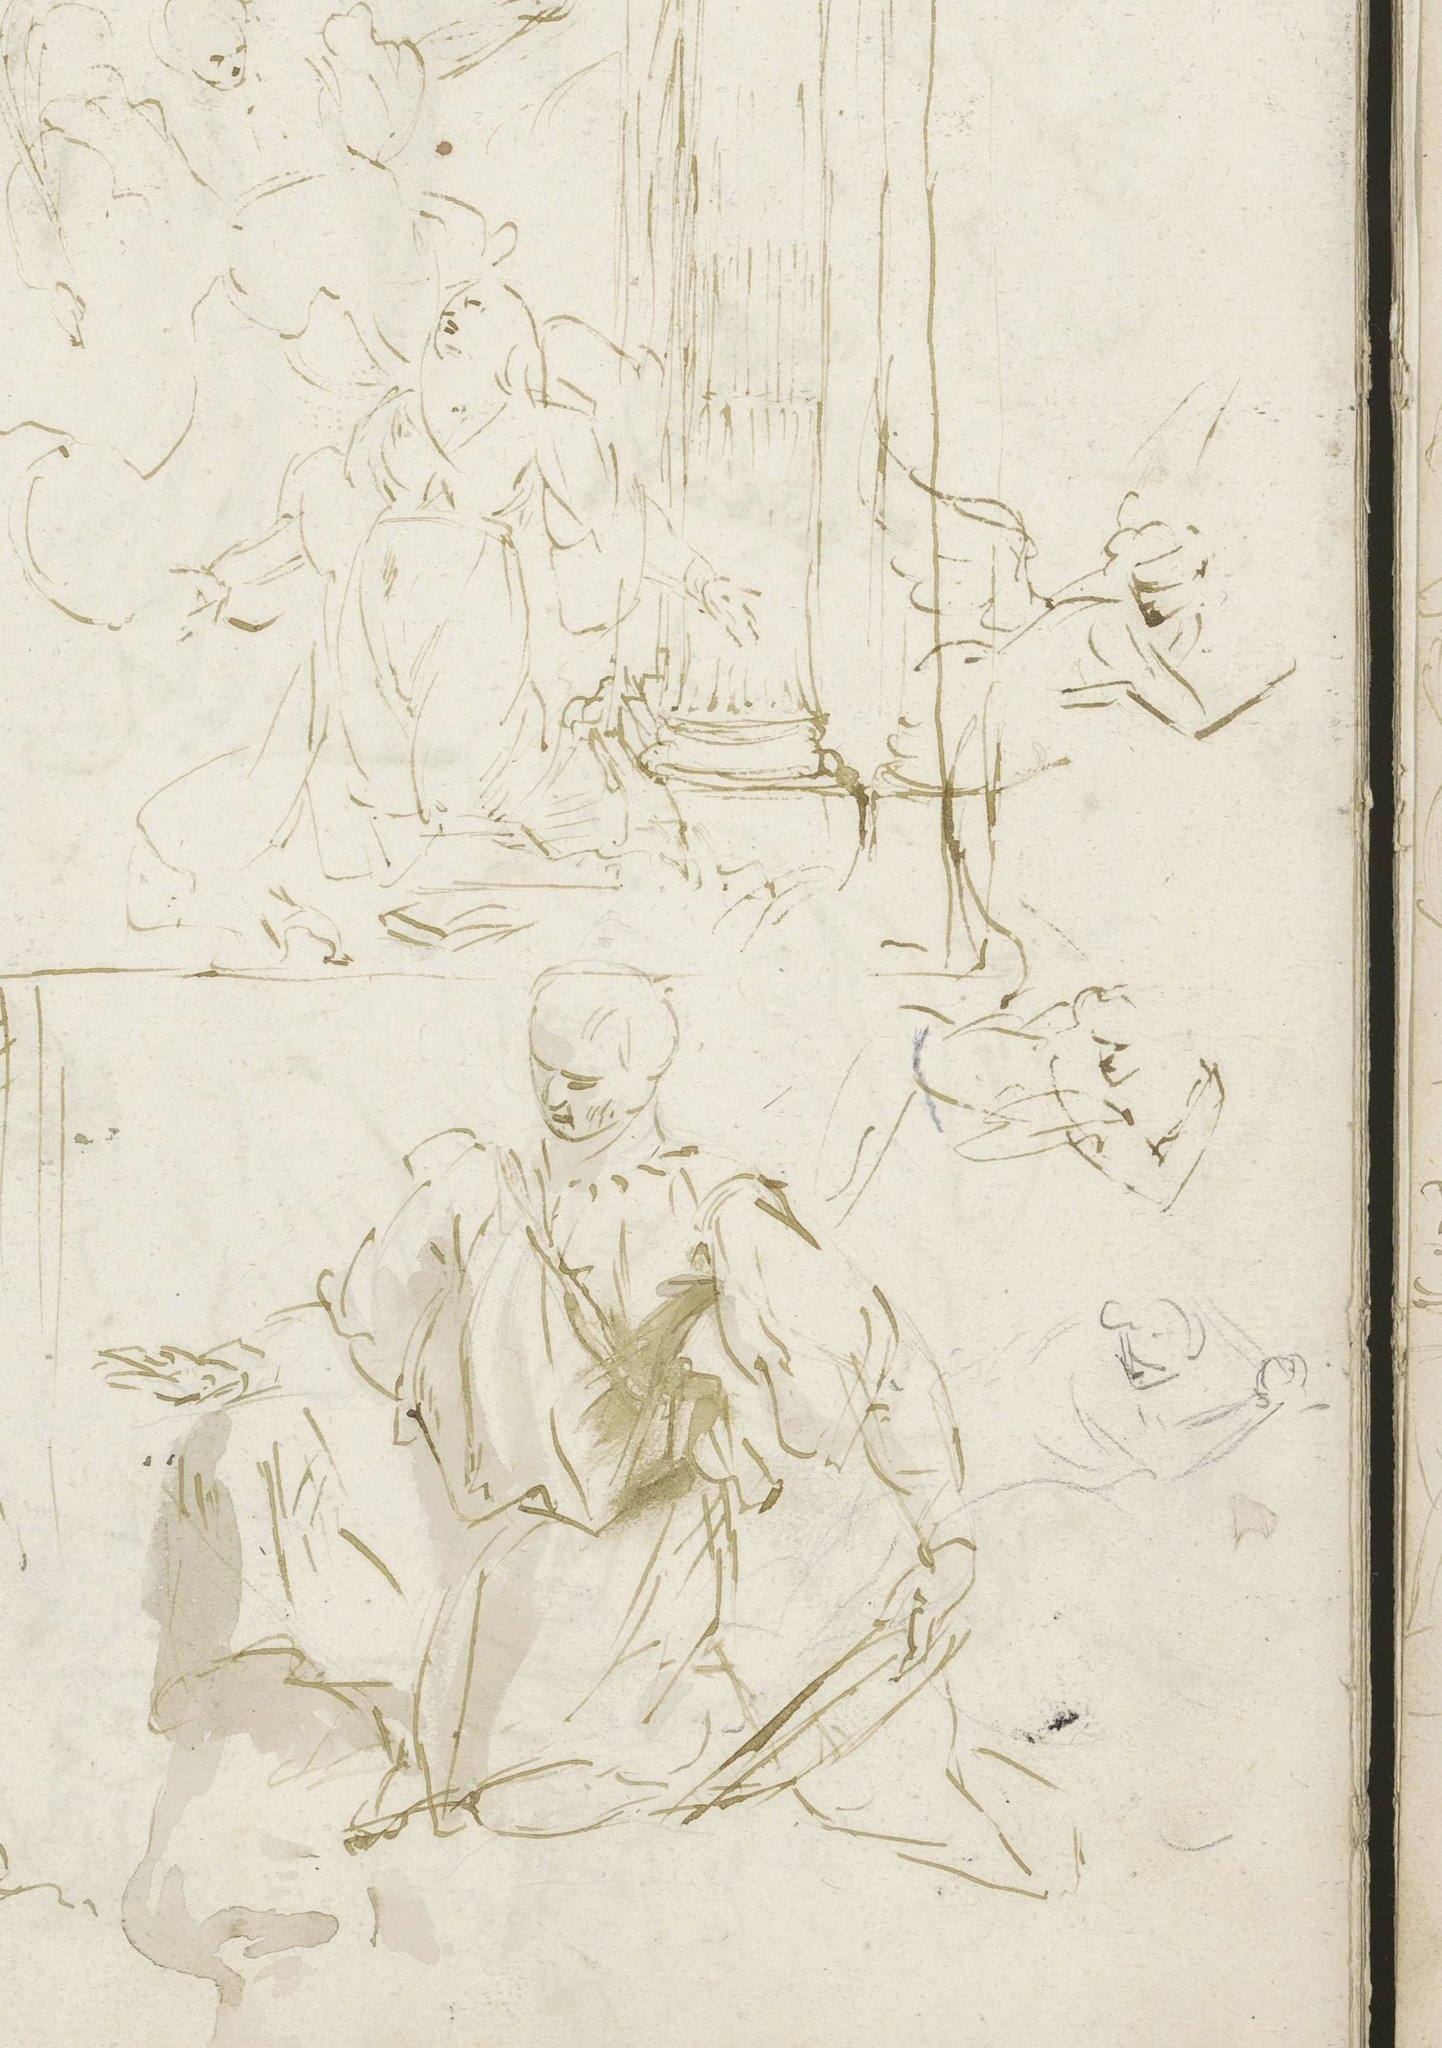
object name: sketchbook leaf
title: Extase van een vrouwelijke heilige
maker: Anonymous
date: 1650-1799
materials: ink, paper, pencil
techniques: brush, pen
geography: italy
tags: head (human), ecstasy, spiritual exaltation, rapture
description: De vrouwelijke heilige zit op de knieën met de armen opgeheven terwijl een engel met palmtak boven haar zweeft. Tevens figuurstudies. Bladzijde 44 uit een schetsboek met 72 bladzijden.